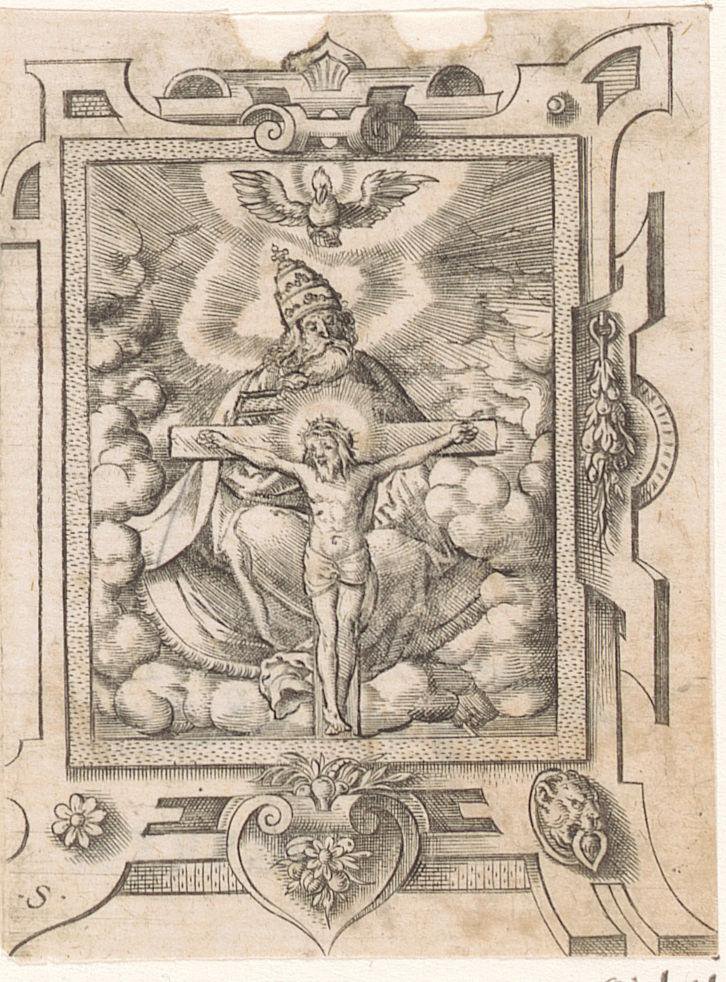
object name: print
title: Drie-eenheid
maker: virgilius solis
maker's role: draughtsman, print maker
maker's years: 1514-1562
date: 1568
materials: paper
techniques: engraving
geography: nuremberg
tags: scrollwork, strapwork ~ ornament, god the father holding the crucified or dead christ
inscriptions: collector's mark: Lugt 240, number: ‘86’, collector's mark: Lugt 2228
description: Prent gebruikt voor het gebedenboek: Solis, Virgil. Ein New Künstlich Betbüchlein. Neurenberg: Hieronymus Petri, 1568. Bij elke prent met een Bijbelse scène behoort een genummerde prent met een gebed in het Latijn en in het Duits. Het monogram VS is steeds verspreid over twee bij elkaar horende prenten.